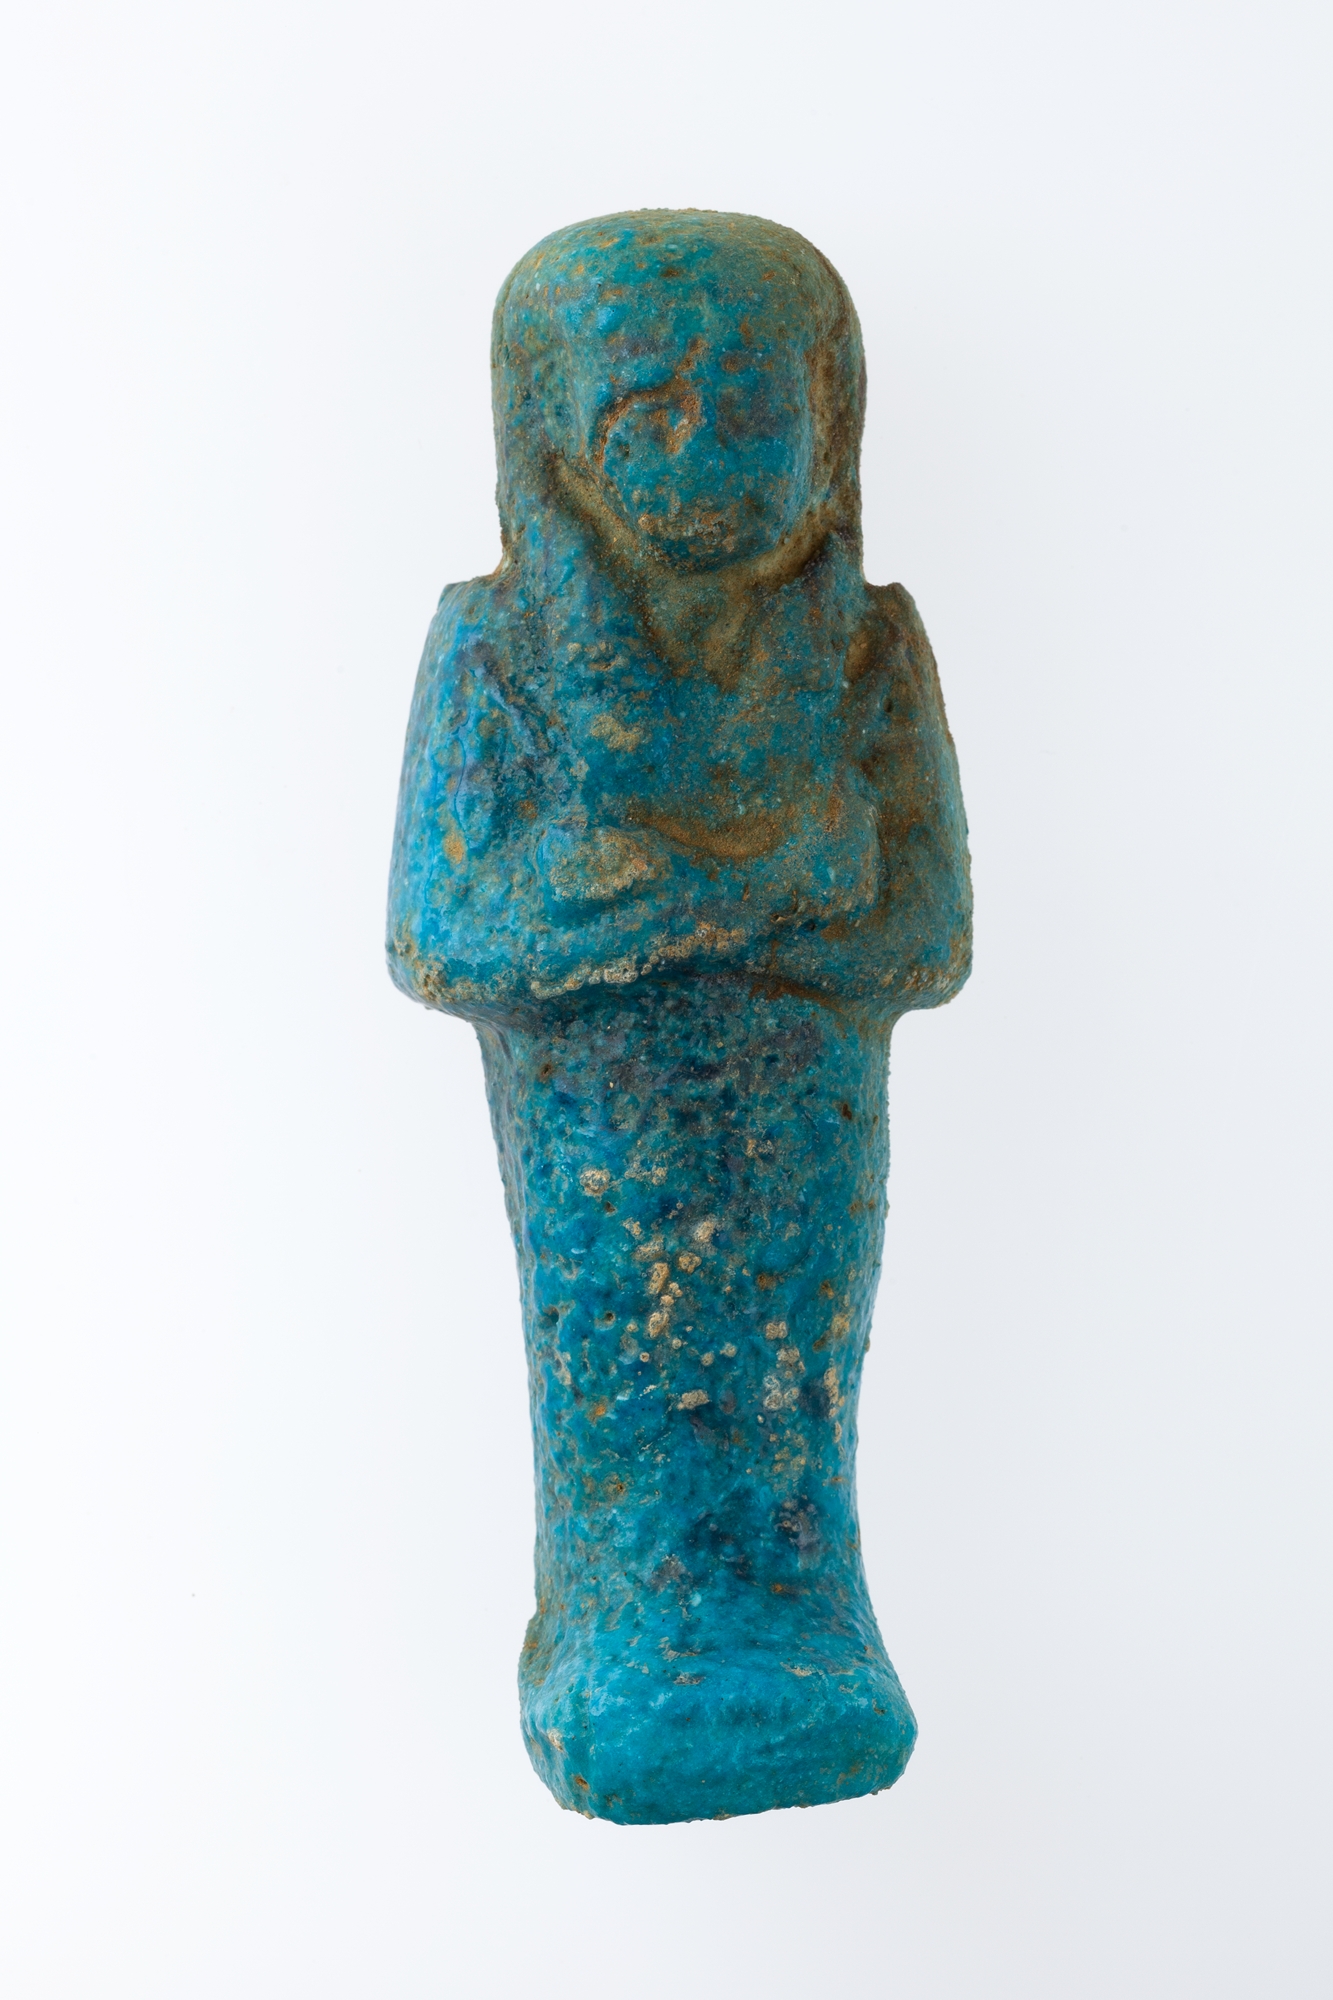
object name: shabti, henettawy c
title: Worker Shabti of Henettawy (C), Daughter of Isetemkheb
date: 990-970 BCE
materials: faience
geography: egypt